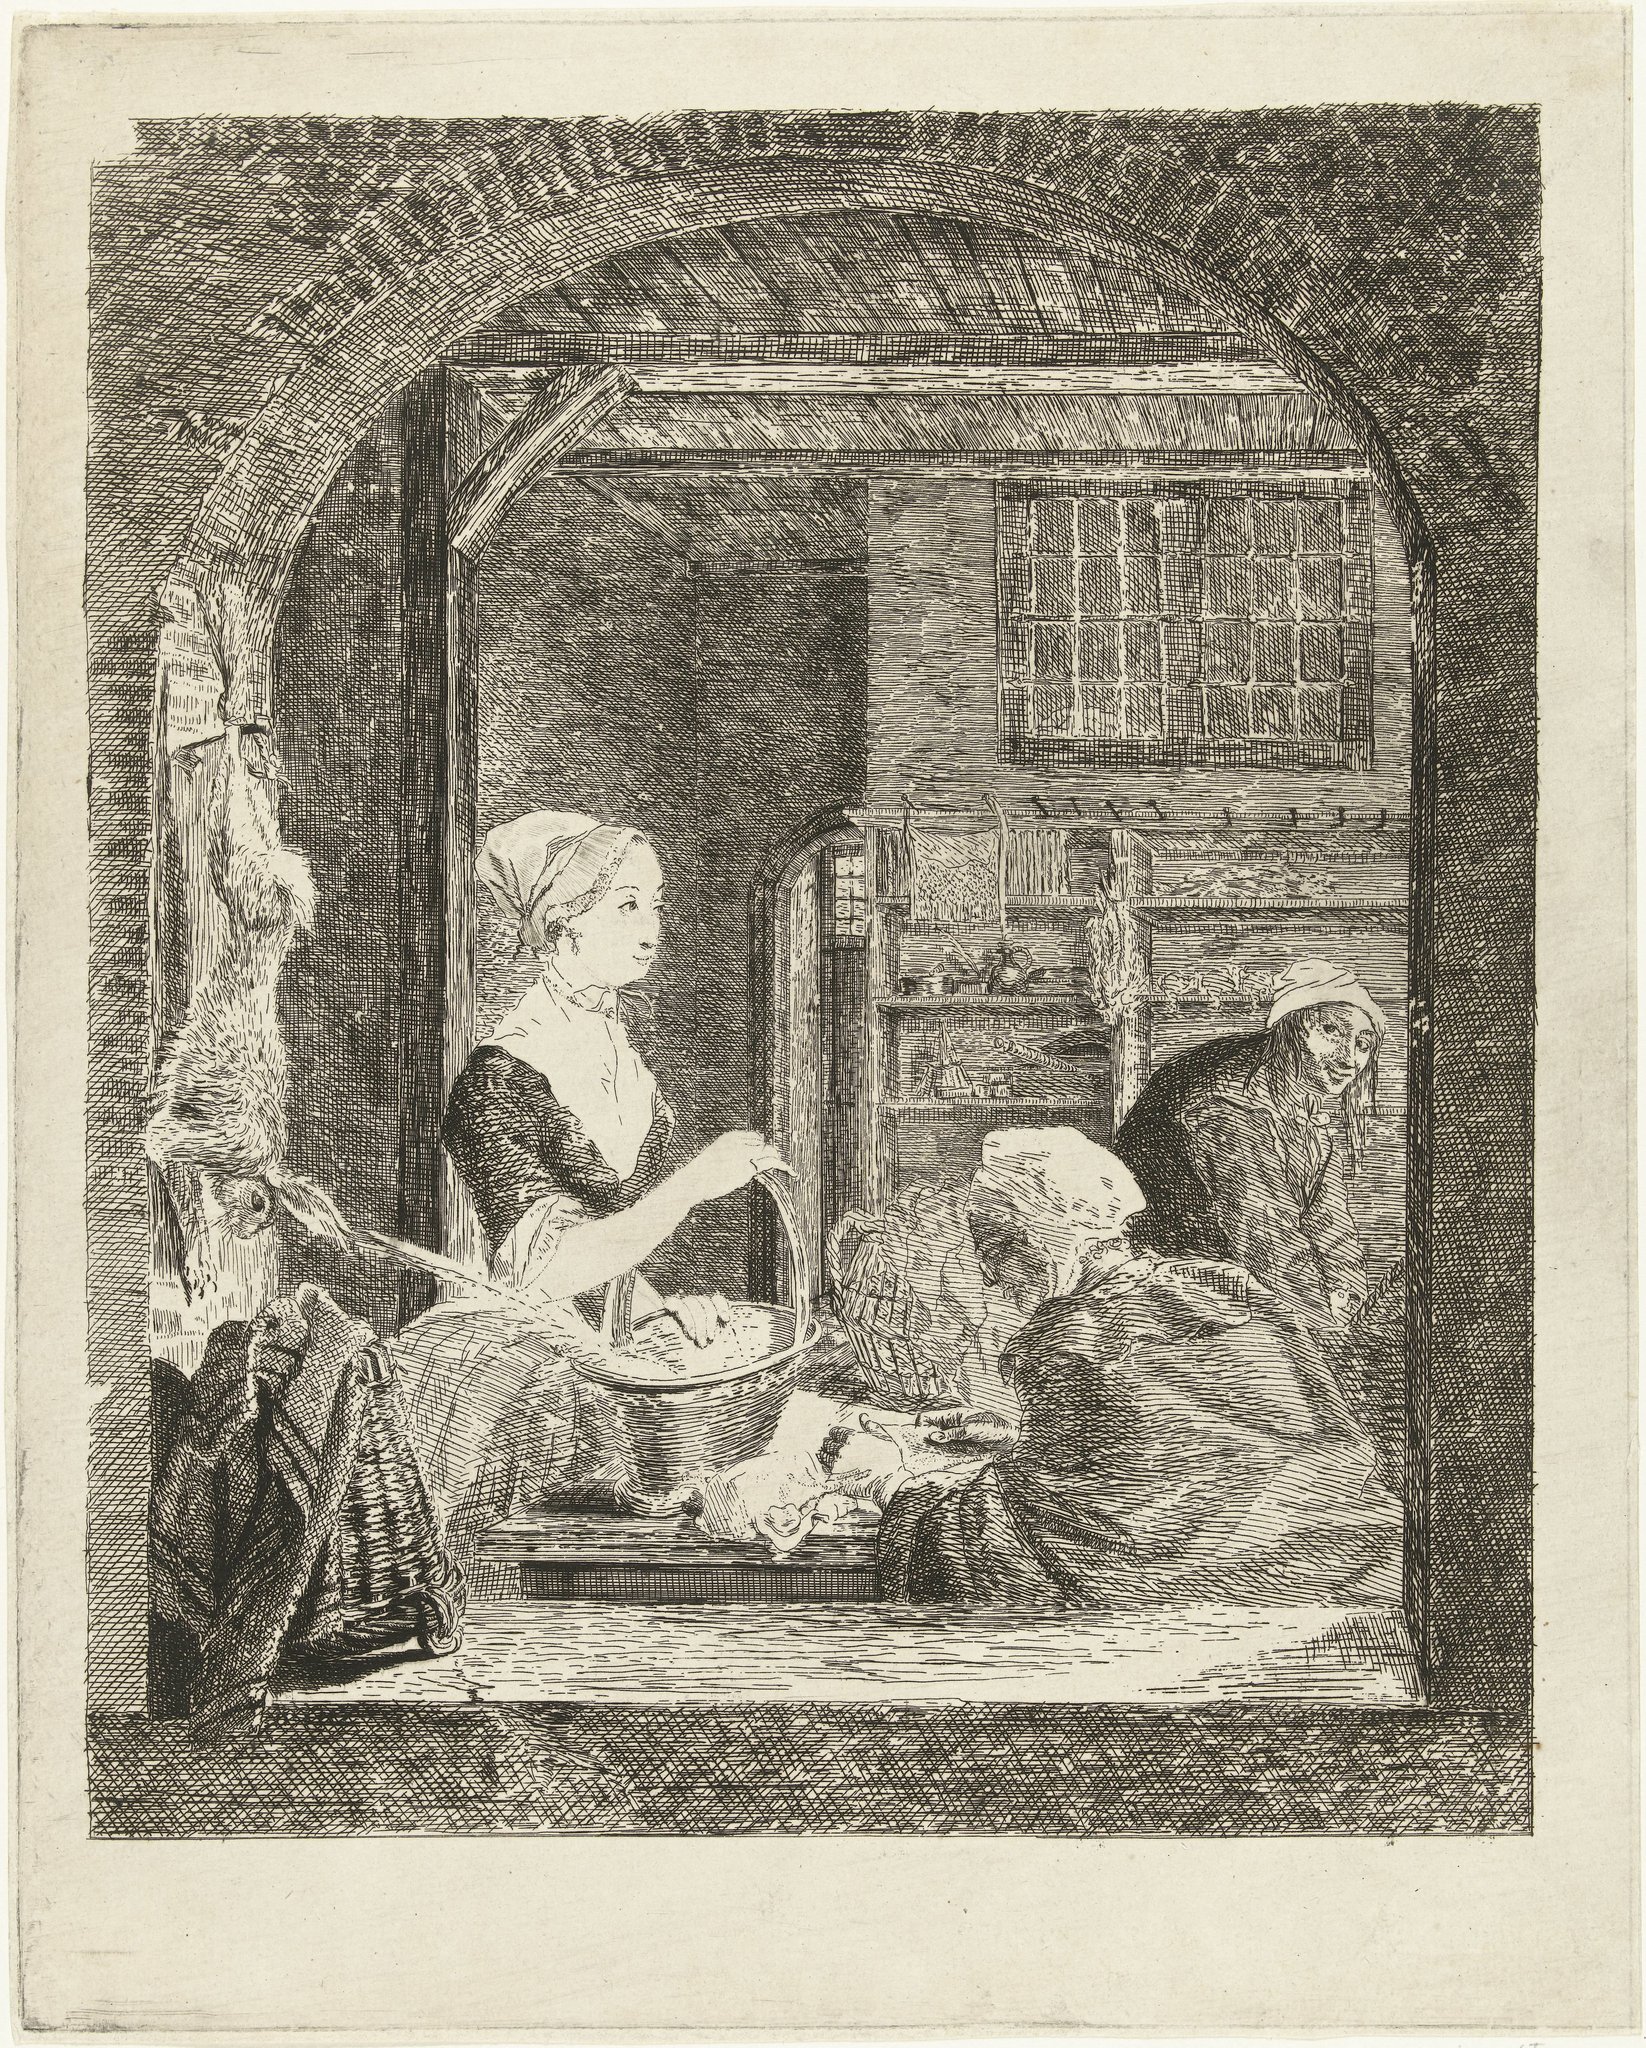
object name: print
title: De poelierster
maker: louis bernard coclers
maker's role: draughtsman, print maker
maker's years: 1741-1817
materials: paper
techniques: etching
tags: shop, store, plucked fowl, butcher, slaughterman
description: Door een nis is de winkelruimte van een poelier te zien. Een jonge vrouw komt haar boodschappen doen. Rechts zit de poelierster aan tafel en bekijkt het boodschappenlijstje van haar klant. Een man met lange haren werkt achter in de winkel.